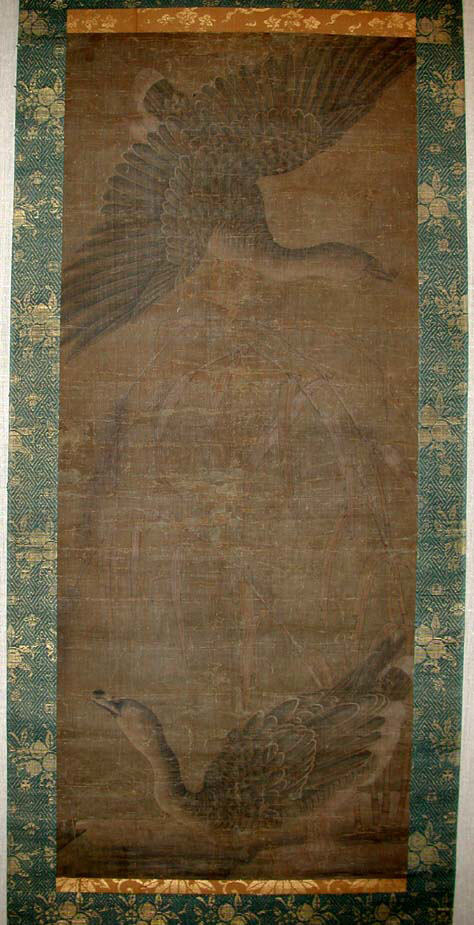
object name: hanging scroll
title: Wild Geese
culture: chinese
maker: unidentified artist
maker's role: artist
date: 1368-1644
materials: silk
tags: geese